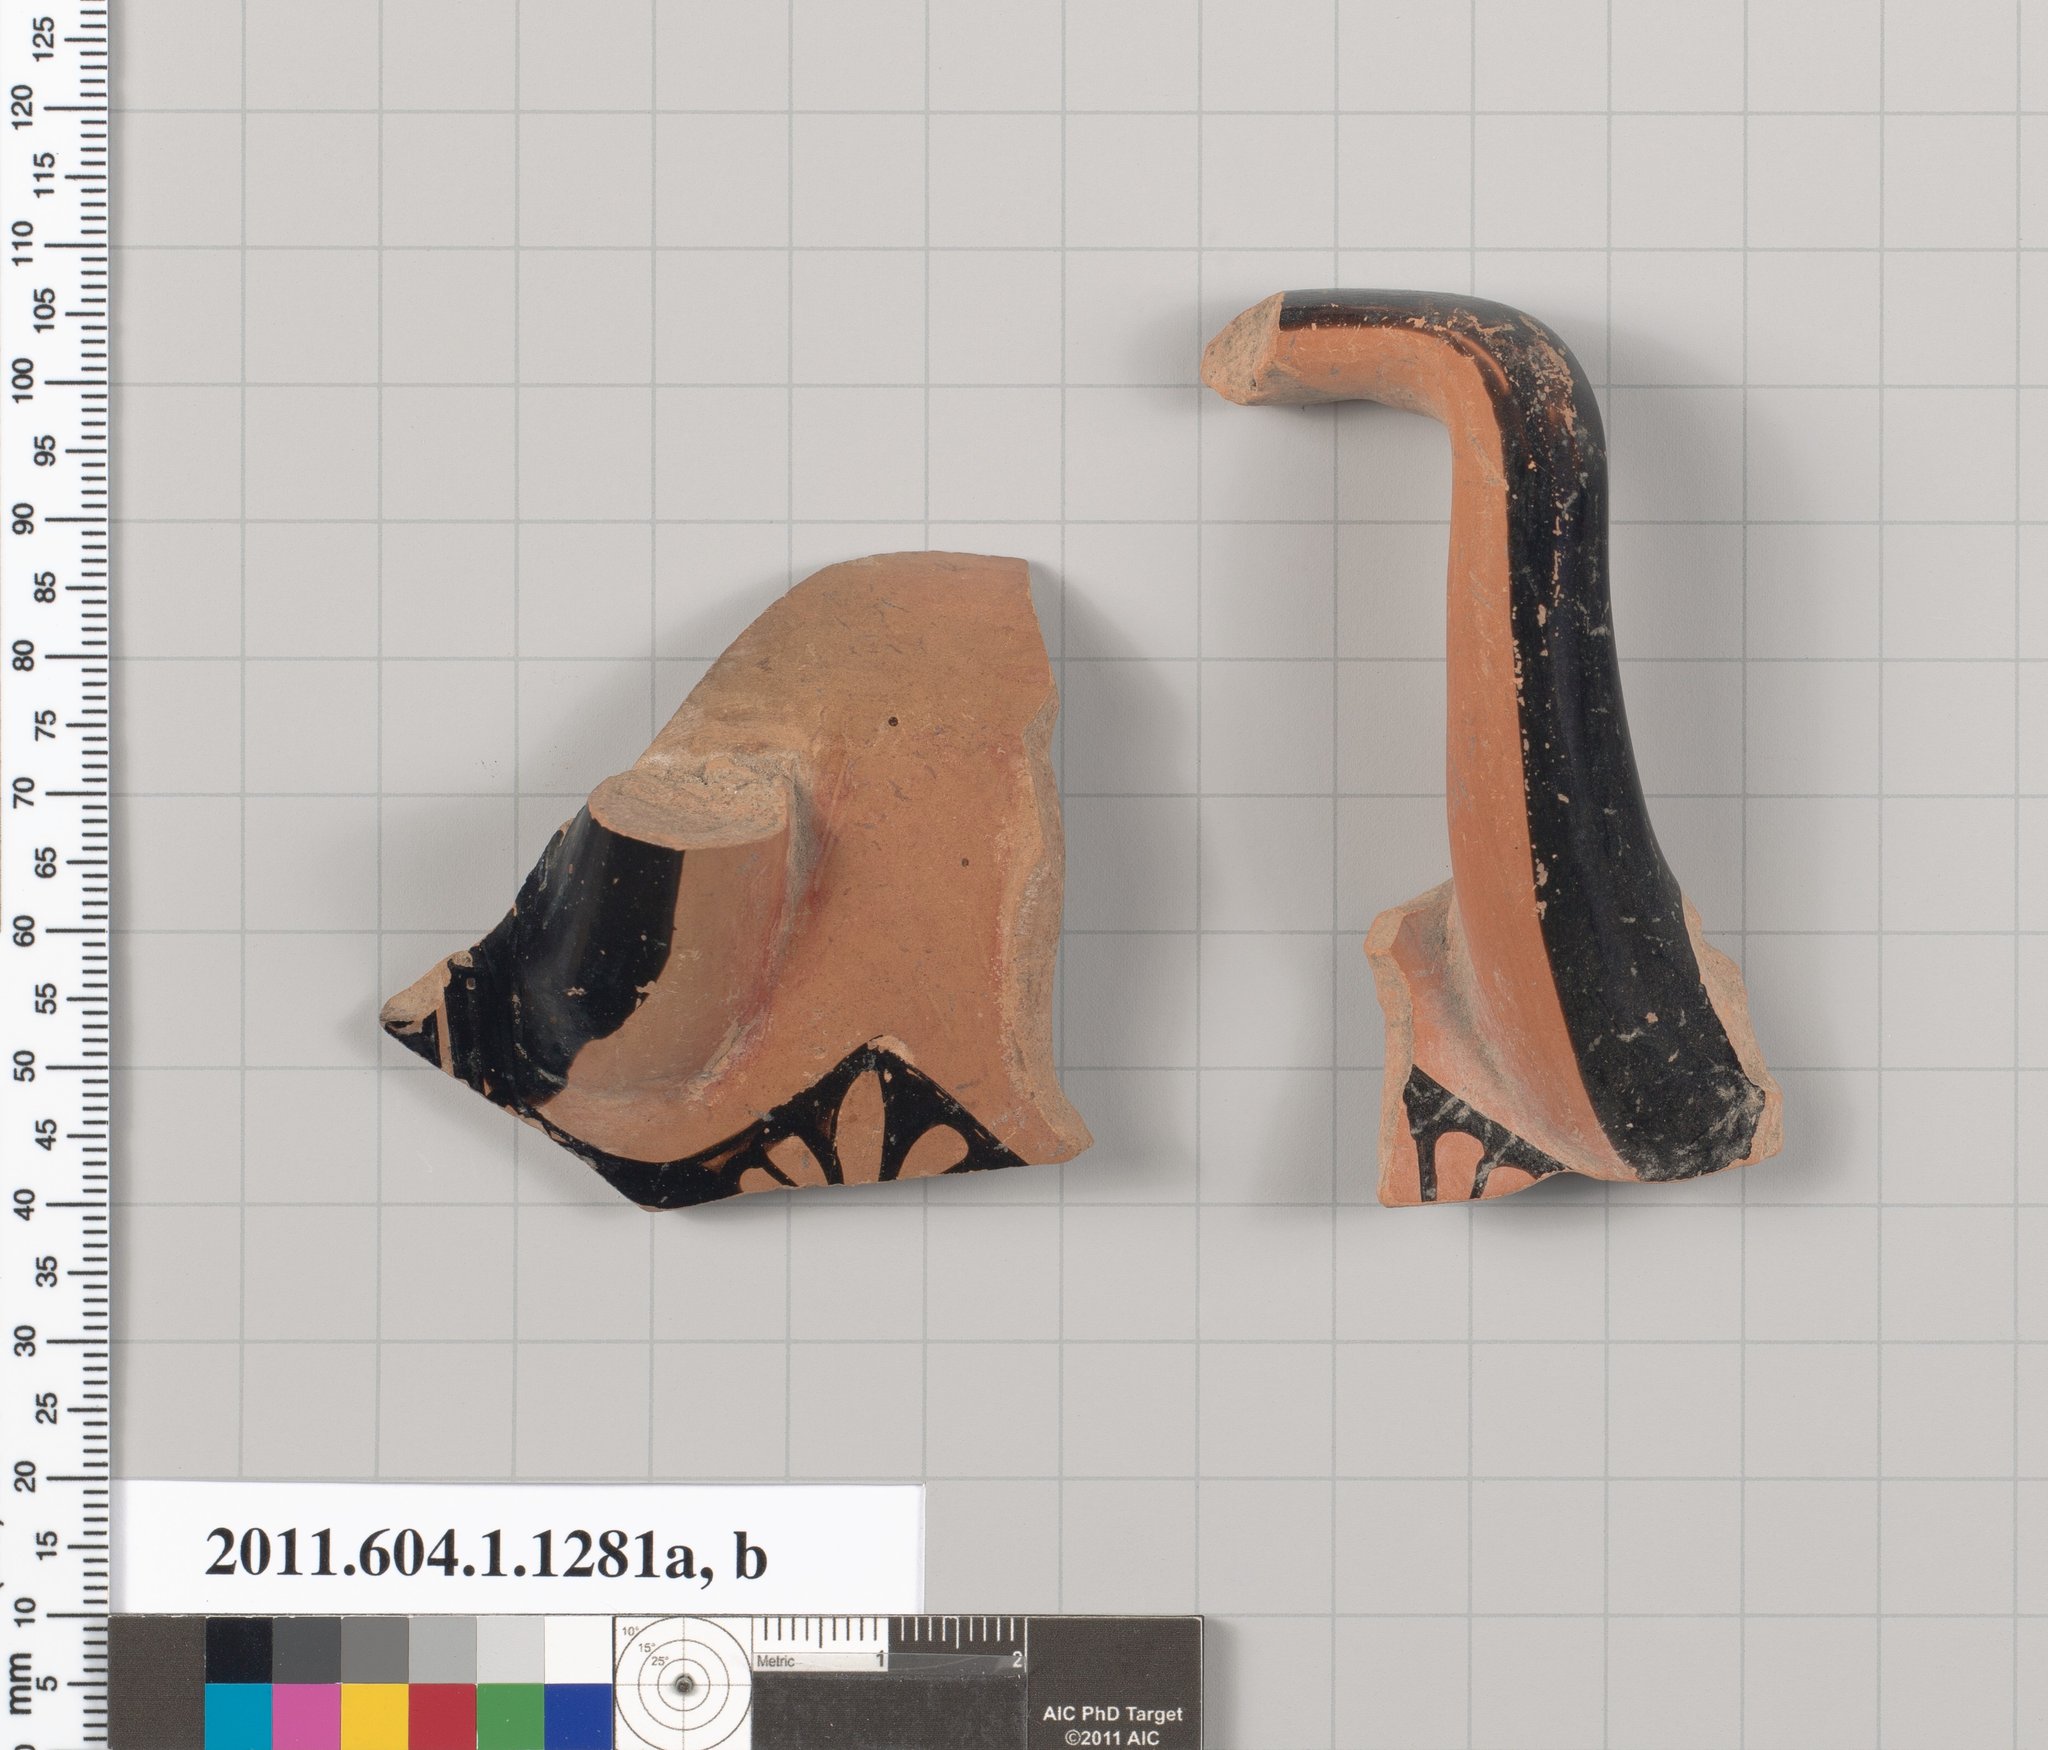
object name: kylix fragment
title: Terracotta fragments of kylikes (drinking cups)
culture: greek, attic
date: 500-401 BCE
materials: terracotta